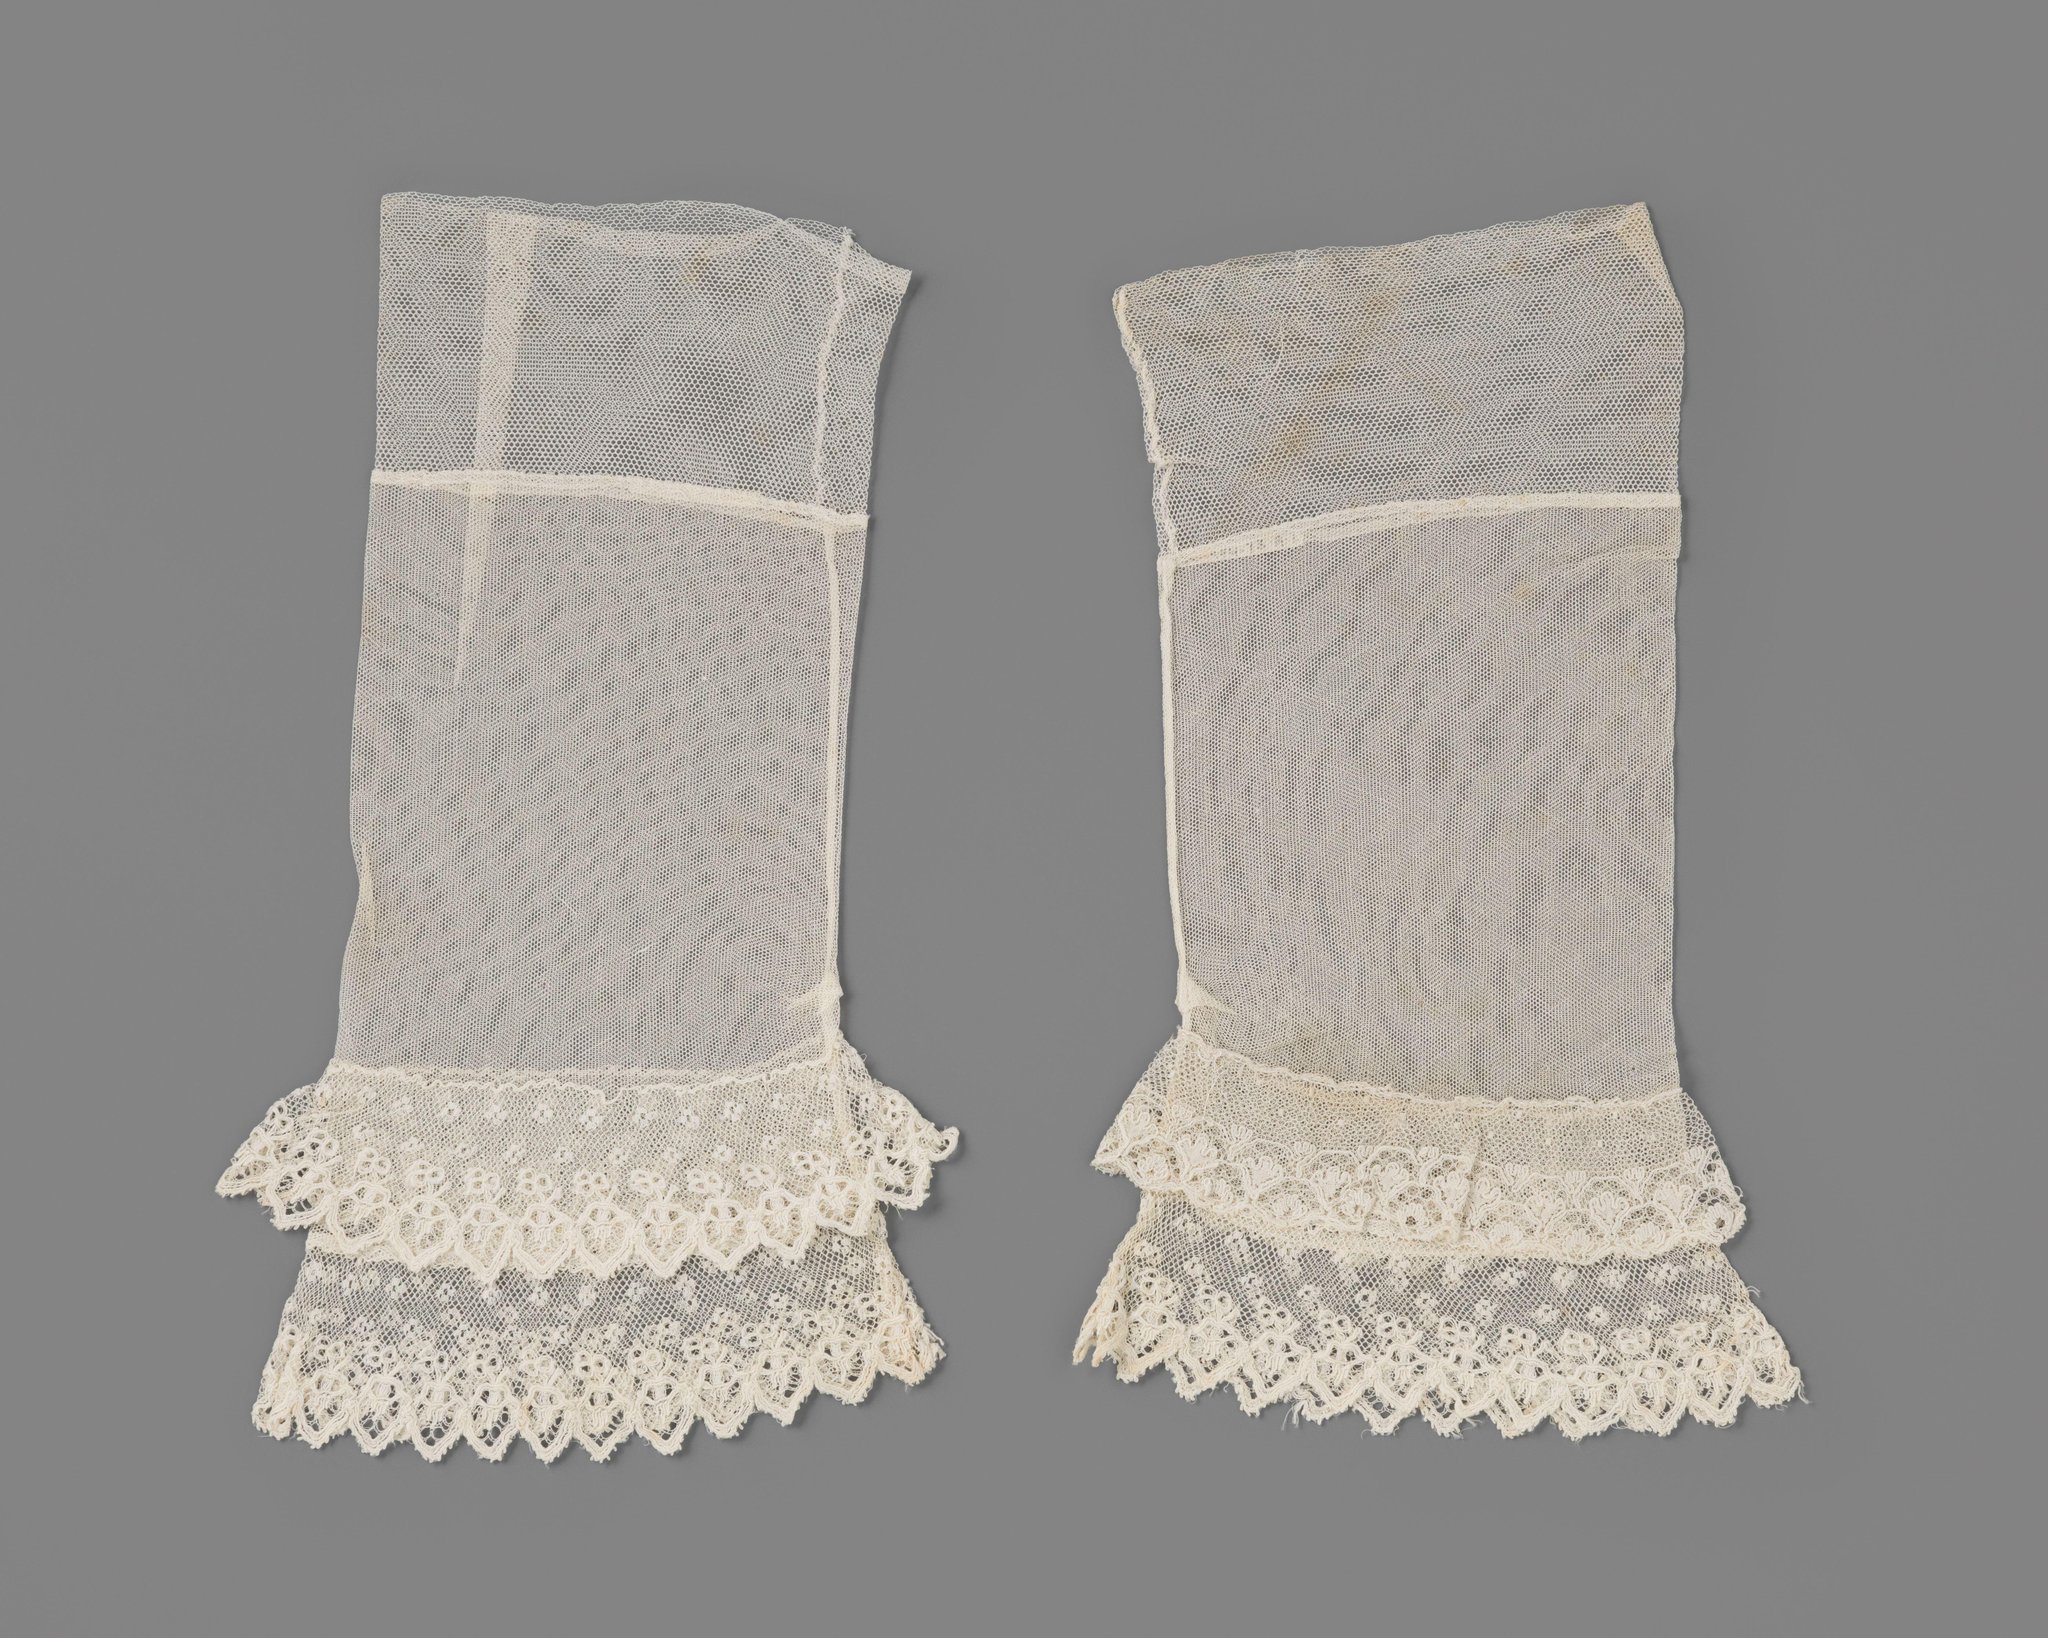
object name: womenswear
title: Ondermouw van tule met manchet bestaande uit twee boven elkaar genaaide stroken kant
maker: Anonymous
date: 1875-1890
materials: lace, fiber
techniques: lace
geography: netherlands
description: Ondermouw van tule, recht model. De manchet bestaat uit twee boven elkaar genaaide stroken kloskant met puntige rand.